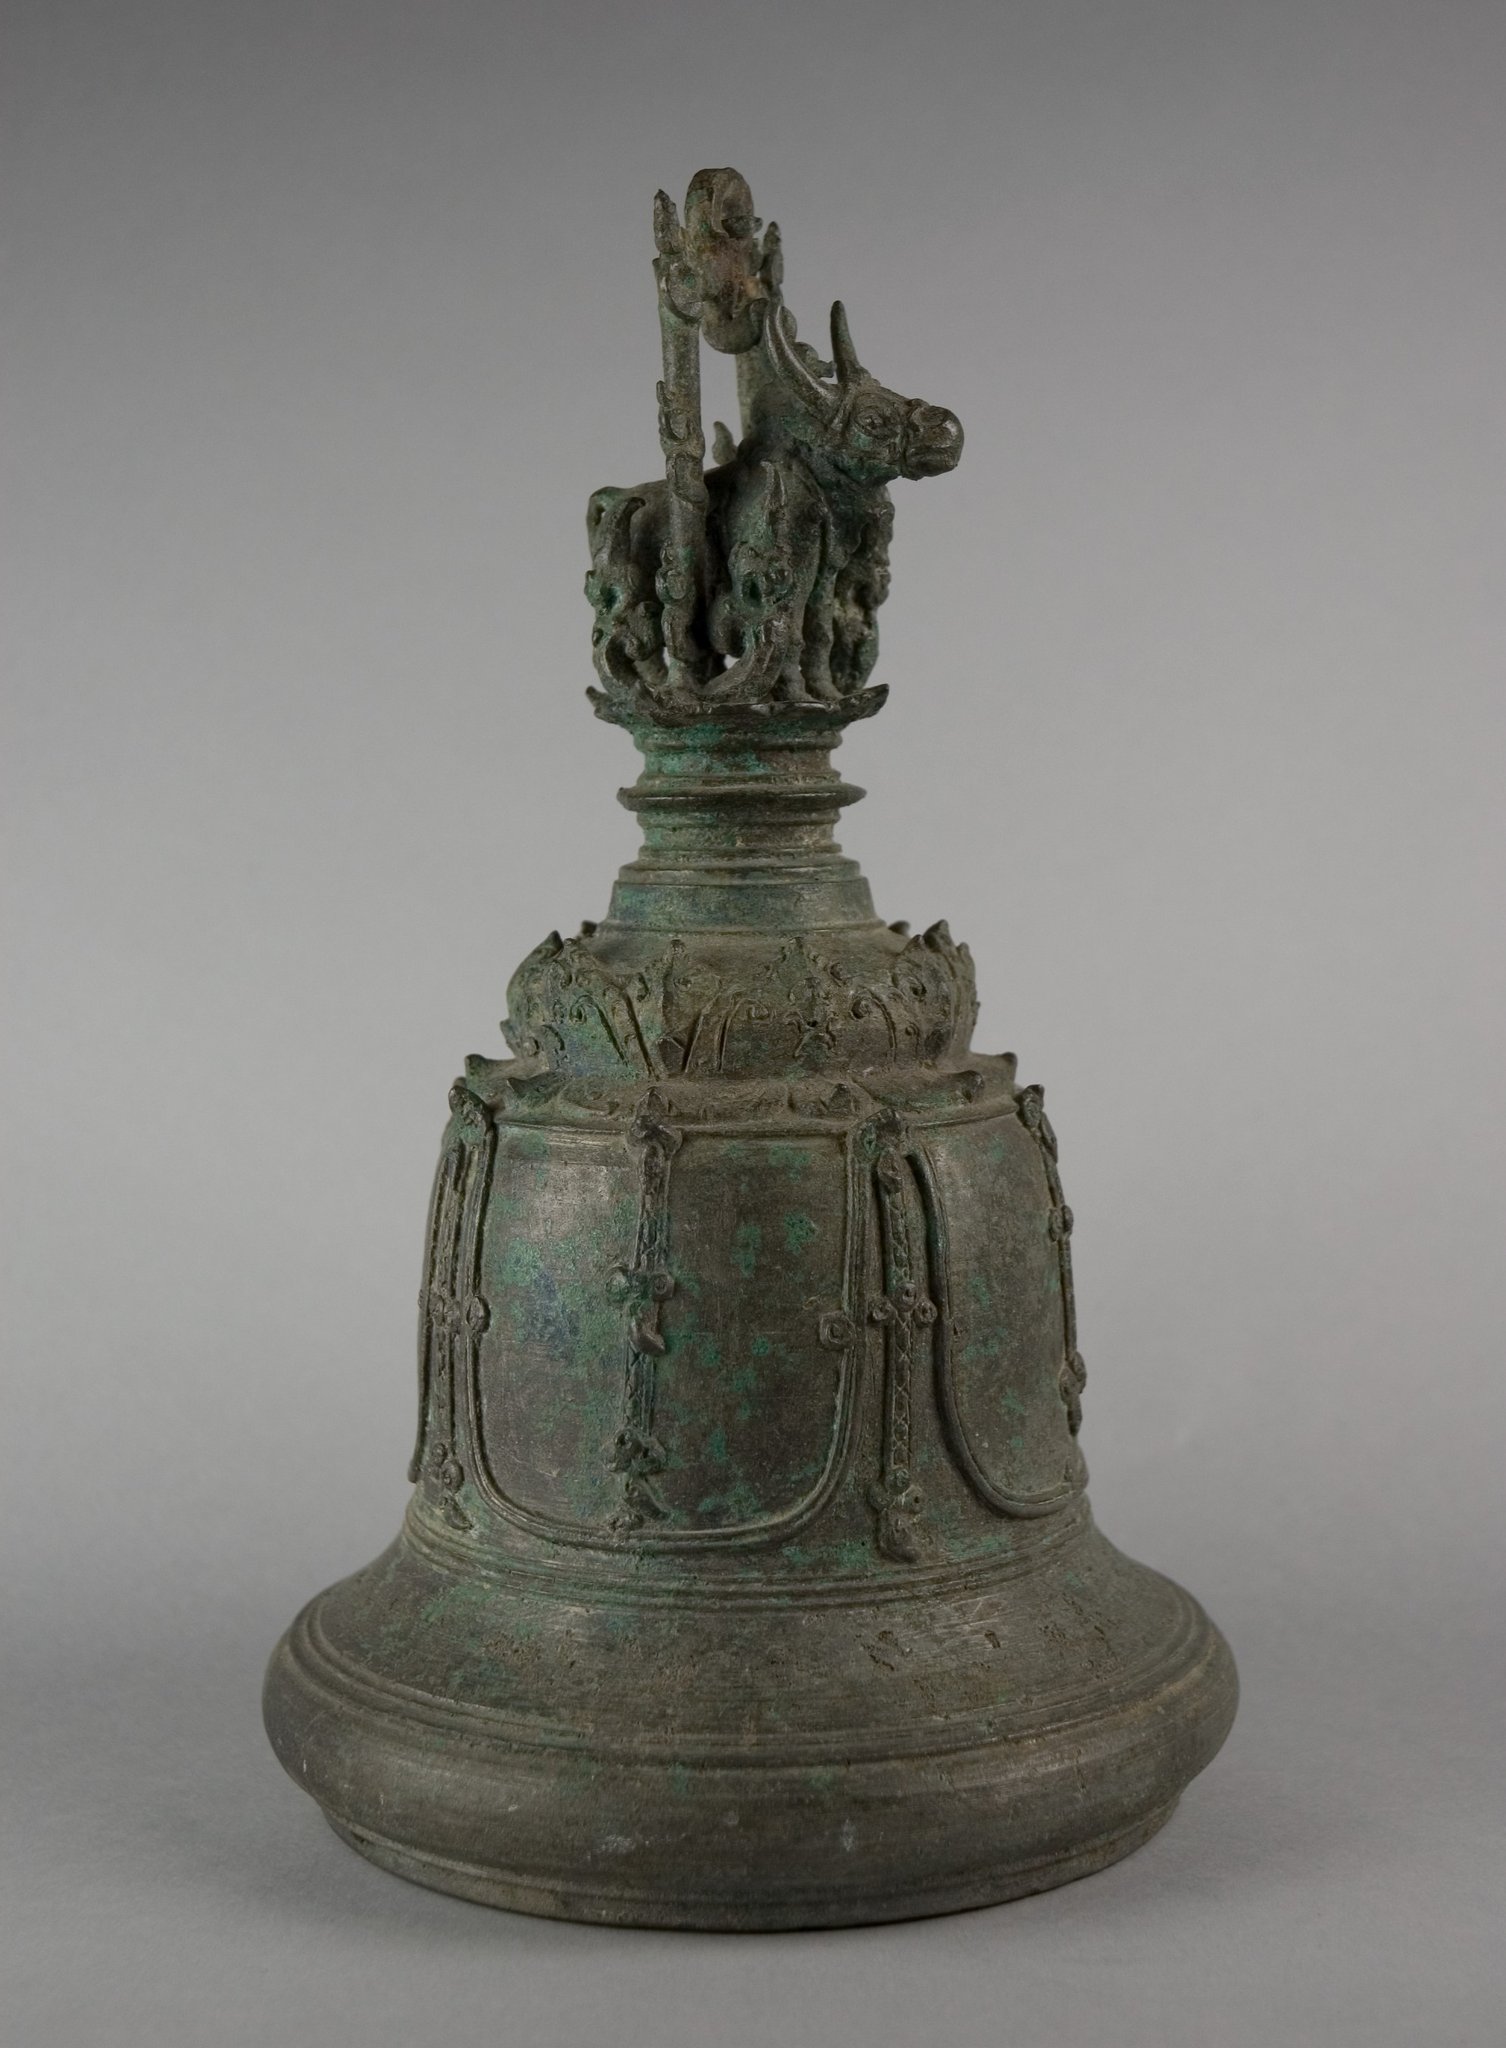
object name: bell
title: Bell with Bull with Chain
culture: indonesian, javanese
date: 901-1100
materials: bronze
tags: musical instruments,bulls